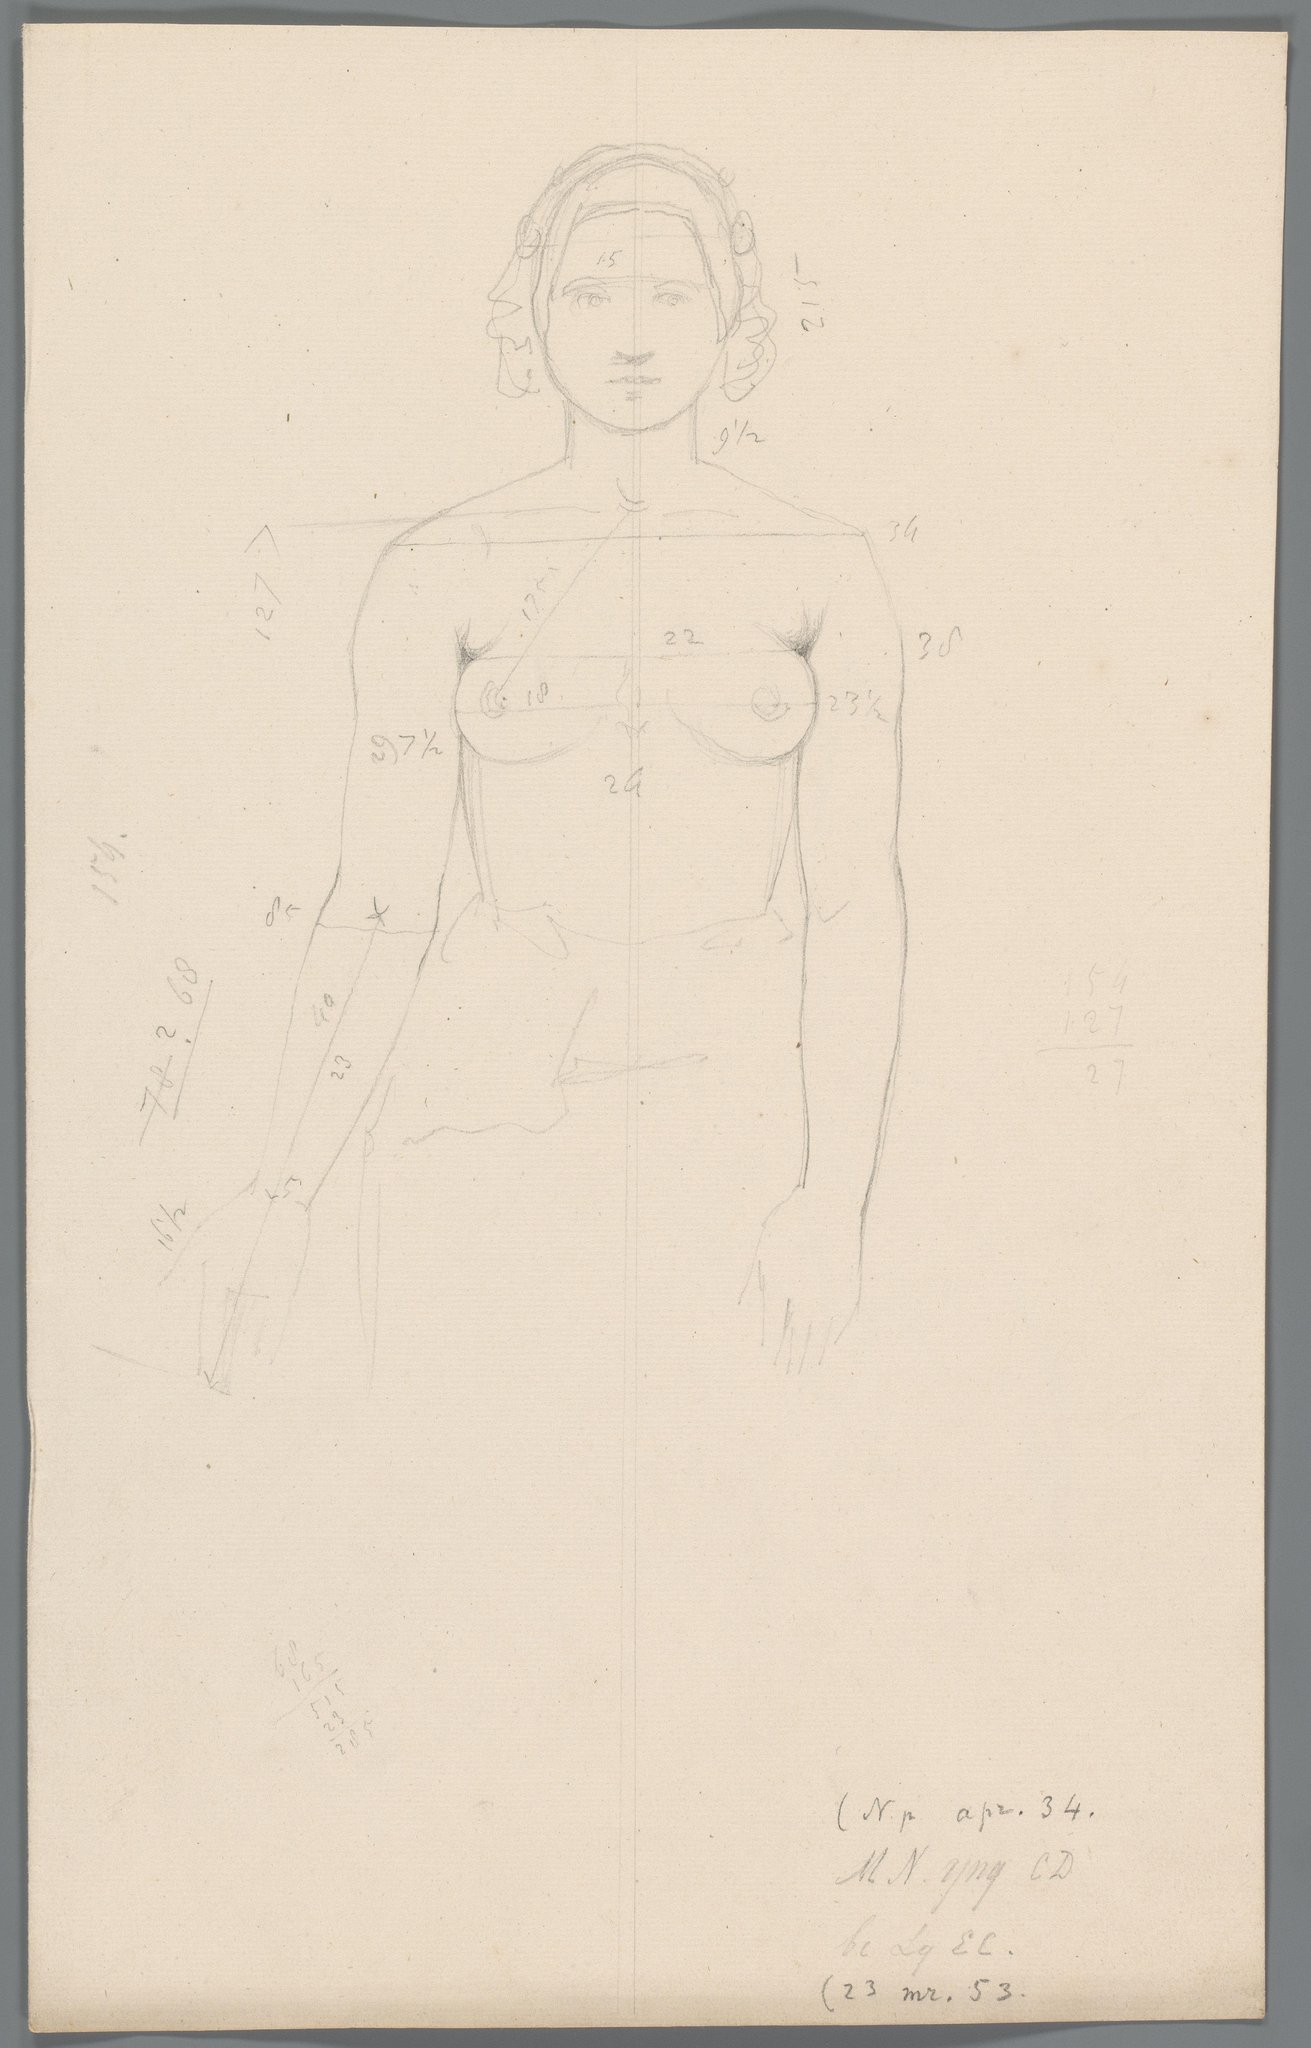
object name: drawing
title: Proportiestudie van een vrouw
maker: jacobus everhardus josephus van den berg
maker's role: draughtsman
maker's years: 1802-1861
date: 1853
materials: paper, pencil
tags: standing figure (canon, proportions) - aa - female human figure, anatomy (non-medical) - aa - female human figure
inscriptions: inscription: ‘Np apr. 34 (...) 23 mr 53.’